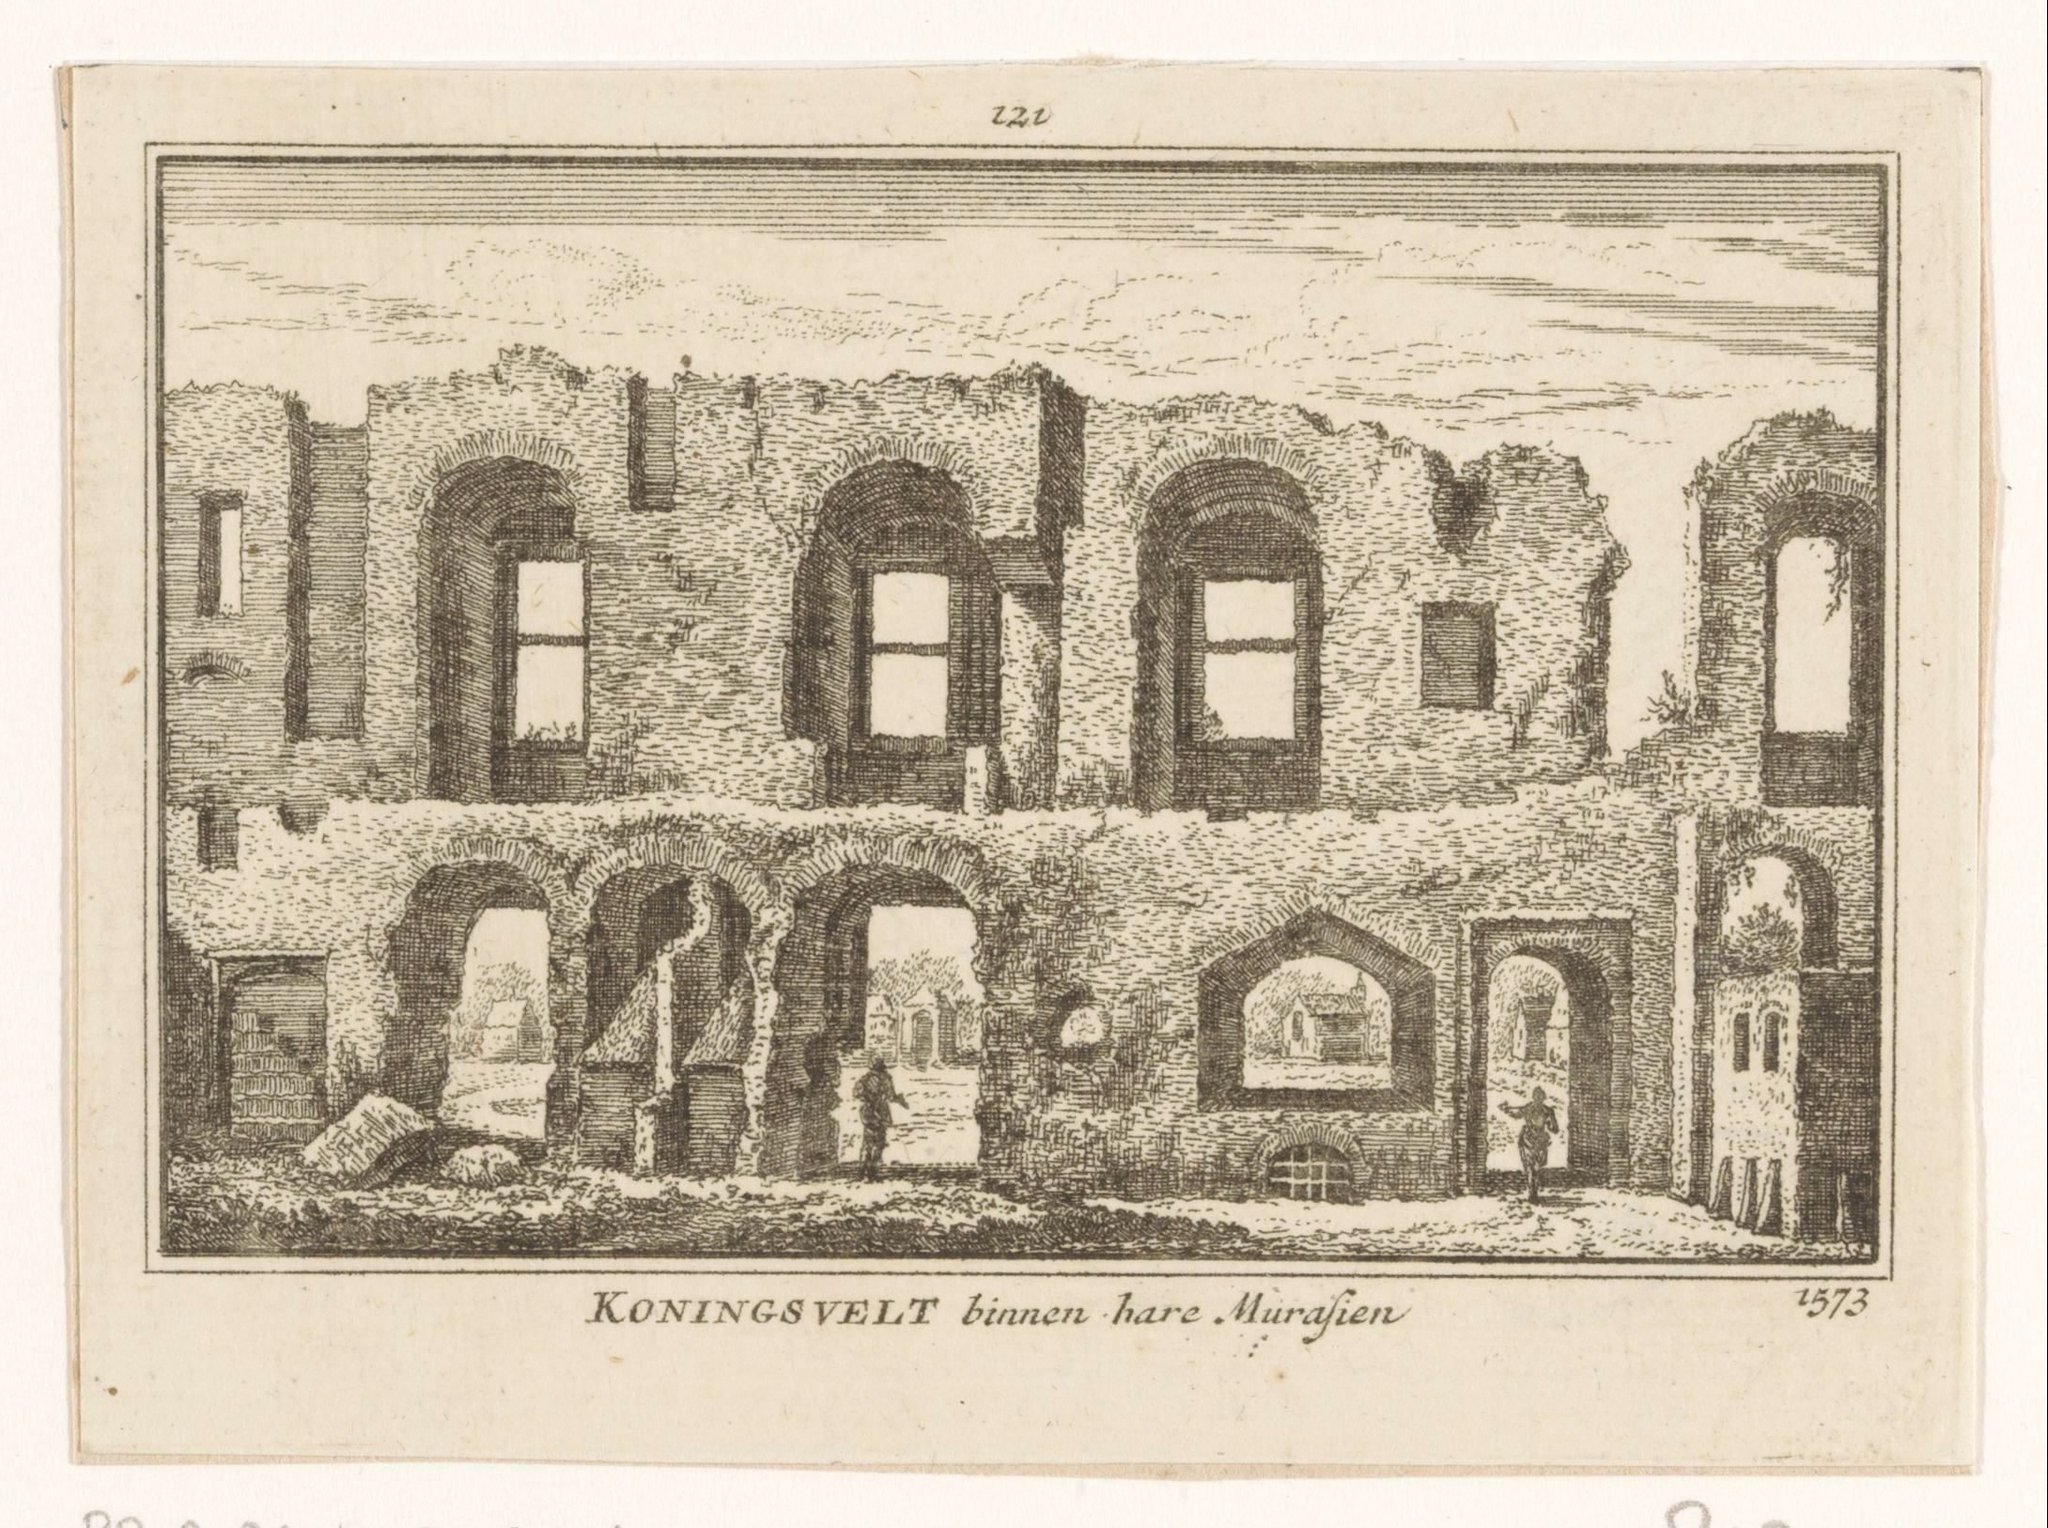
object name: book illustration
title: Gezicht op het geruïneerde interieur van het klooster Koningsveld, 1573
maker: abraham rademaker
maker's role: draughtsman, print maker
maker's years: 1676-1735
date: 1725-1803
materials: paper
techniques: engraving, etching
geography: amsterdam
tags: ruin of church, monastery, etc.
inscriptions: collector's mark: Lugt 2228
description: Prent ook gebruikt in: Rademaker, Abraham. Kabinet van Nederlandsche outheden en gezichten: vervat in 300 konstplaaten (…). 2 delen. Amsterdam: Willem Barents, 1725, dl. 1, ill. 121. Na 1725 is deze prent nog in verschillende heruitgaven verschenen, uitgegeven in 1727-1733, 1770-1771 en 1792-1803. Uit welke uitgave het huidige exemplaar precies komt is niet na te gaan.